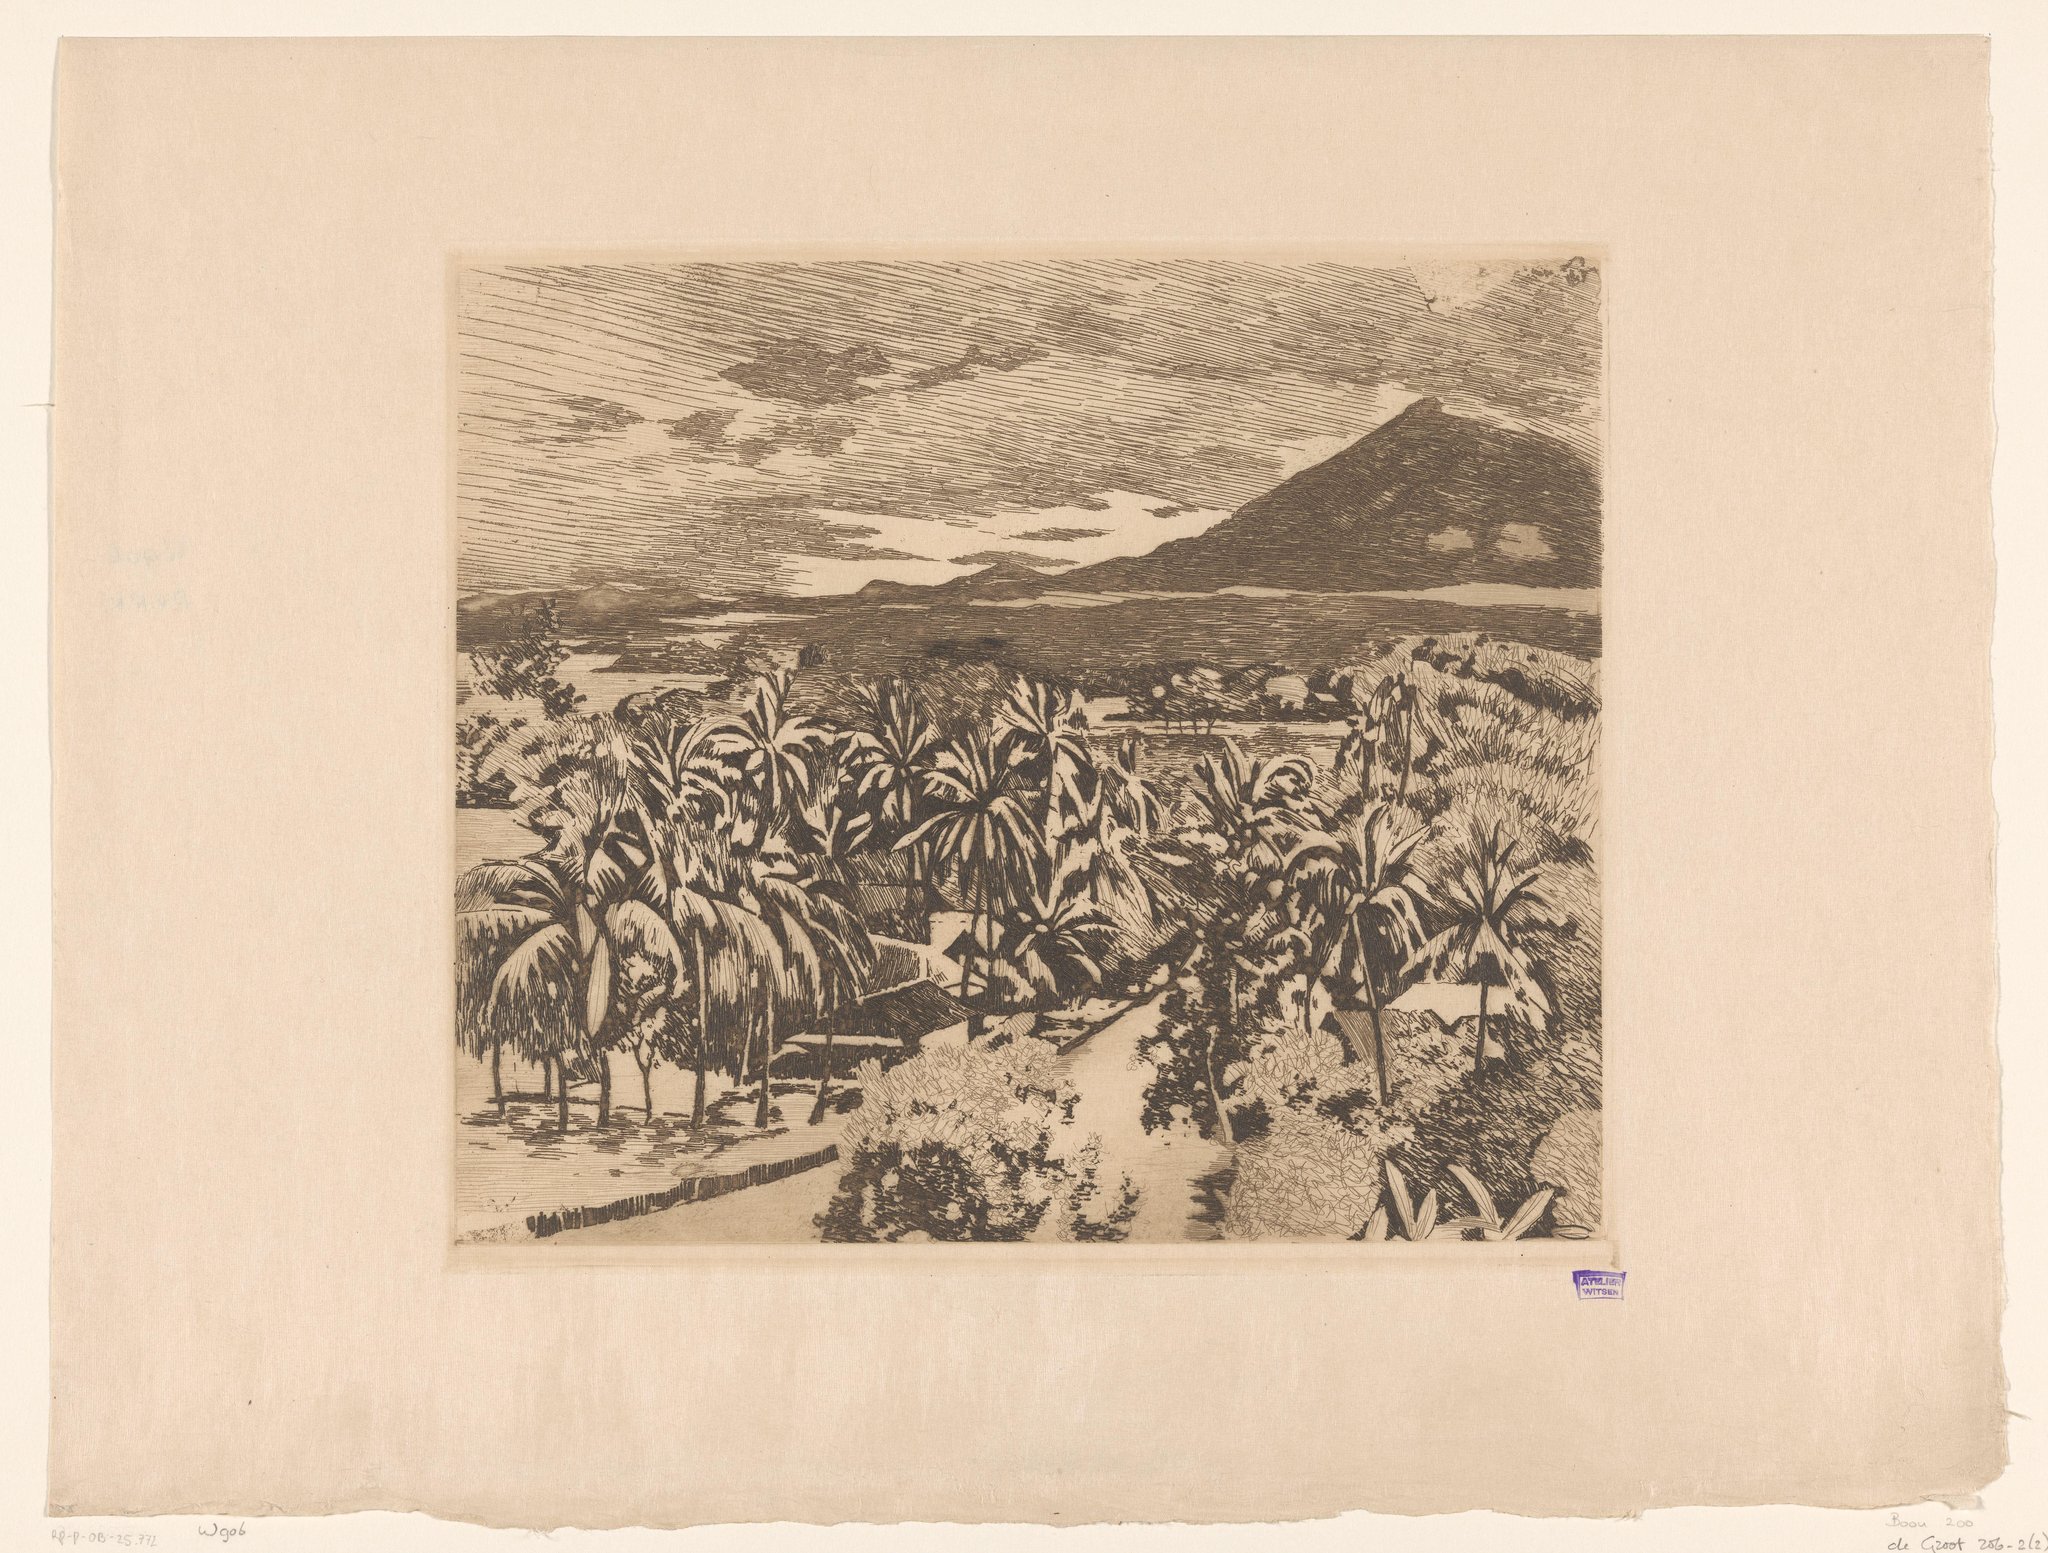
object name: print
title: Gezicht op een landschap met klapperbomen in Buitenzorg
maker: willem witsen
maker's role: draughtsman, painter, print maker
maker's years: 1860-1923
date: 1921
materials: paper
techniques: etching, intaglio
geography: amsterdam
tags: landscapes in tropical and sub-tropical regions - kk - ideal landscapes, trees: palm-tree, volcano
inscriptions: collector's mark: Lugt 2583b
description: Gezien vanuit Hotel Bellevue in Buitenzorg. Rechtsachter een vulkaan.